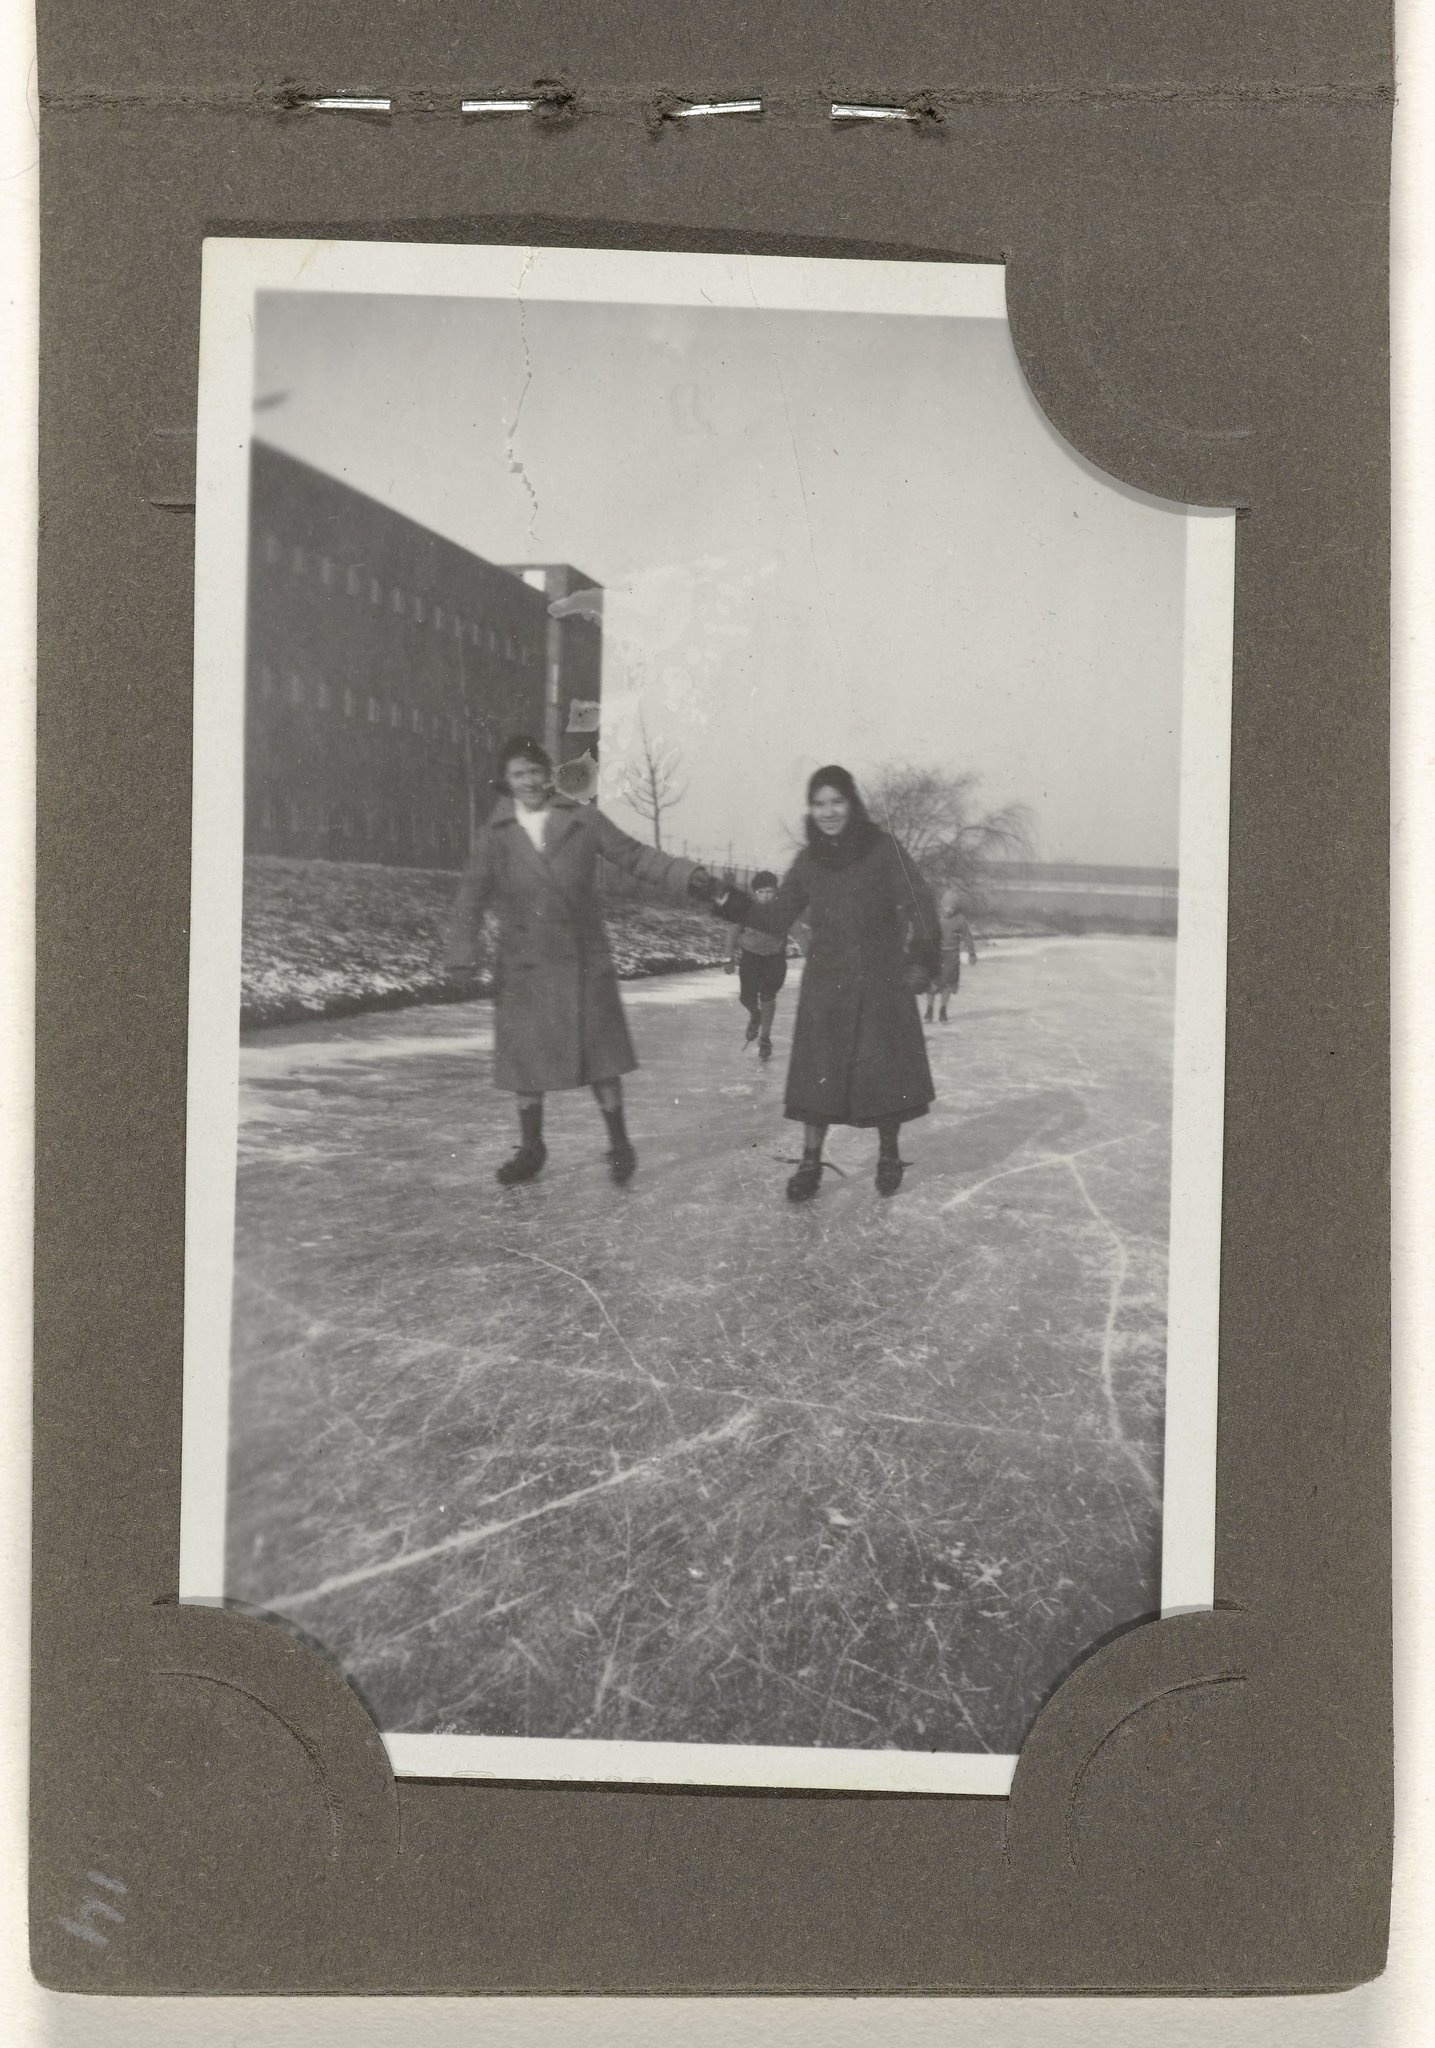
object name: photograph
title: Schaatsen, februari 1933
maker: Anonymous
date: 1902-1933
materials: photographic support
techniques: gelatin silver print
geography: rotterdam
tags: wim van den bosch, rotterdam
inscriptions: date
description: Twee vrouwen hand in hand schaatsend op het ijs, februari 1933. Onderdeel van het familiealbum 1933-1944.